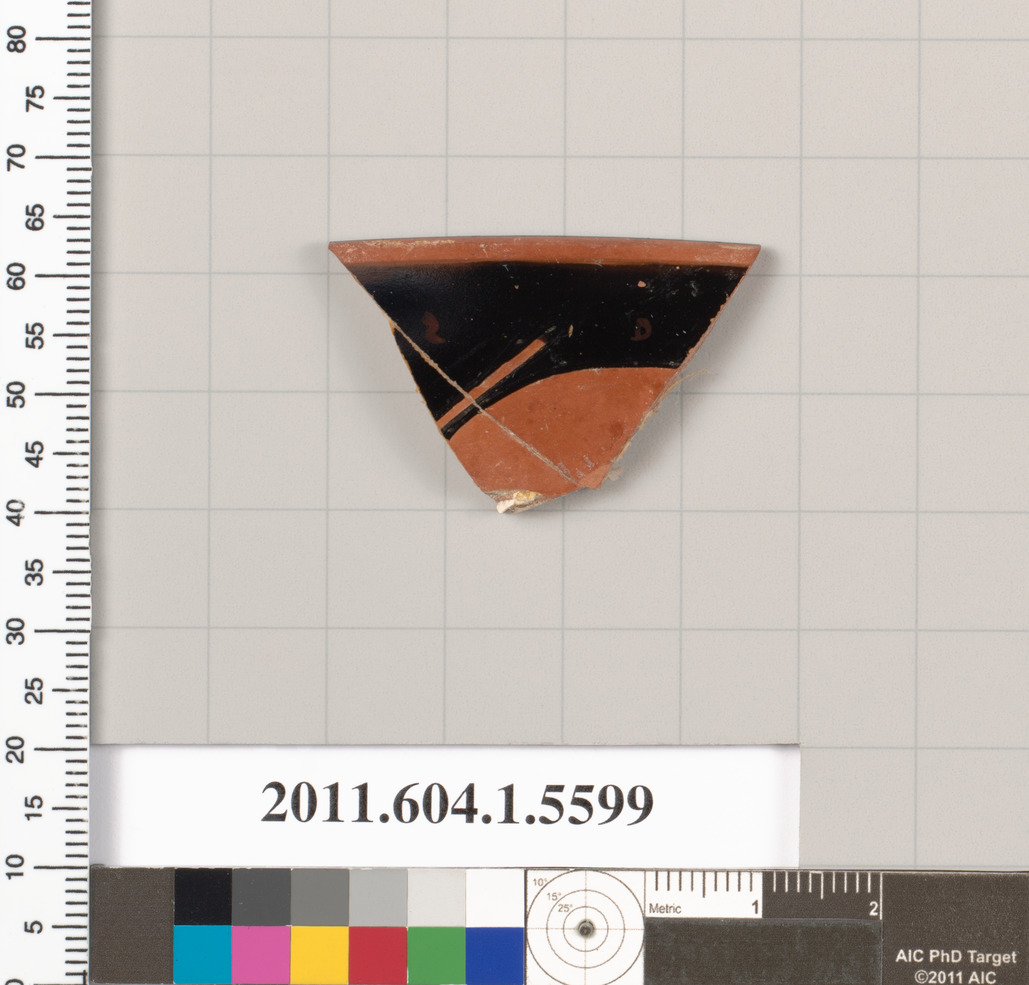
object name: kylix fragment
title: Terracotta rim fragment of a kylix (drinking cup)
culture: greek, attic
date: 500-490 BCE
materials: terracotta